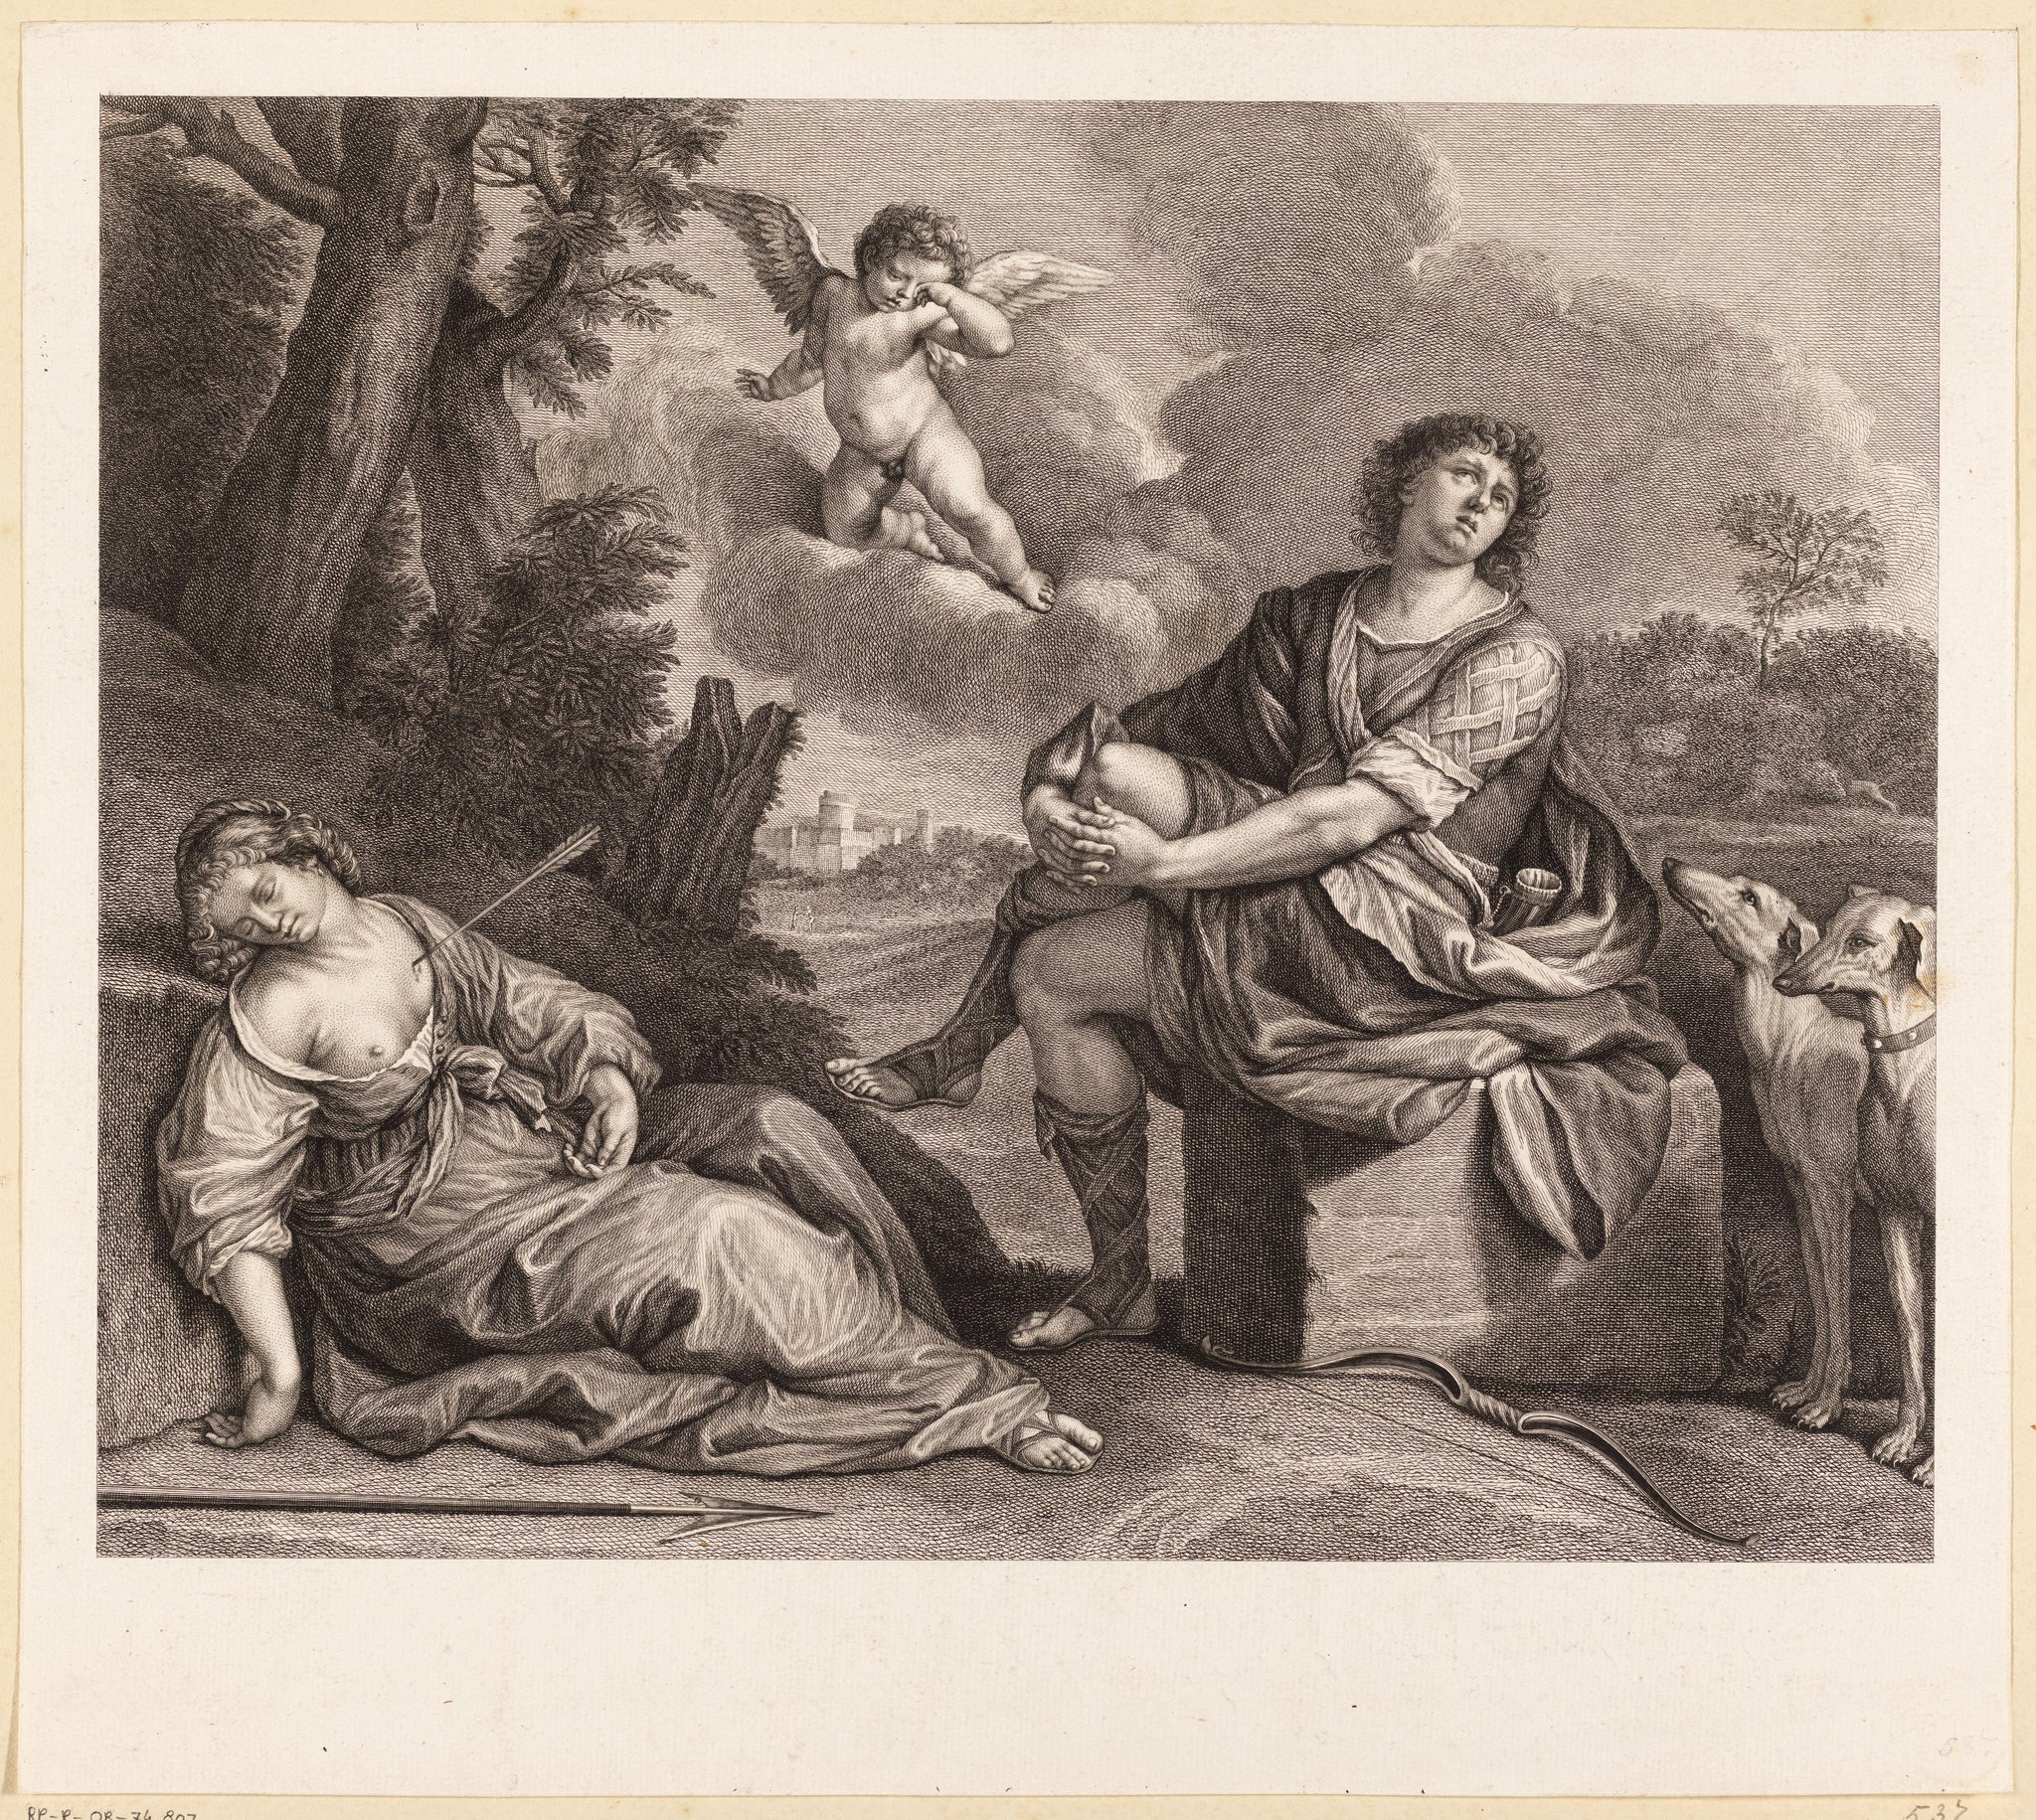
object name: print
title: Cephalus en Procris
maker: louis simon lempereur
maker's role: print maker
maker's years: 1728-1807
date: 1750-1757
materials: paper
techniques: engraving, etching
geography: france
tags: mourning of procris, hunting accidents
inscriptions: collector's mark: Lugt 240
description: Prent gebruikt voor de 'Recueil d'estampes d'après les plus célèbres tableaux de la Galerie Royale de Dresde', verschenen in twee delen in 1753 en 1757, met in totaal 100 prenten naar schilderijen in de koninklijke kunstcollecties te Dresden. Dit betreft plaat 22. Voor een latere staat zie British Museum, inv.nr. 1855,0609.1296.